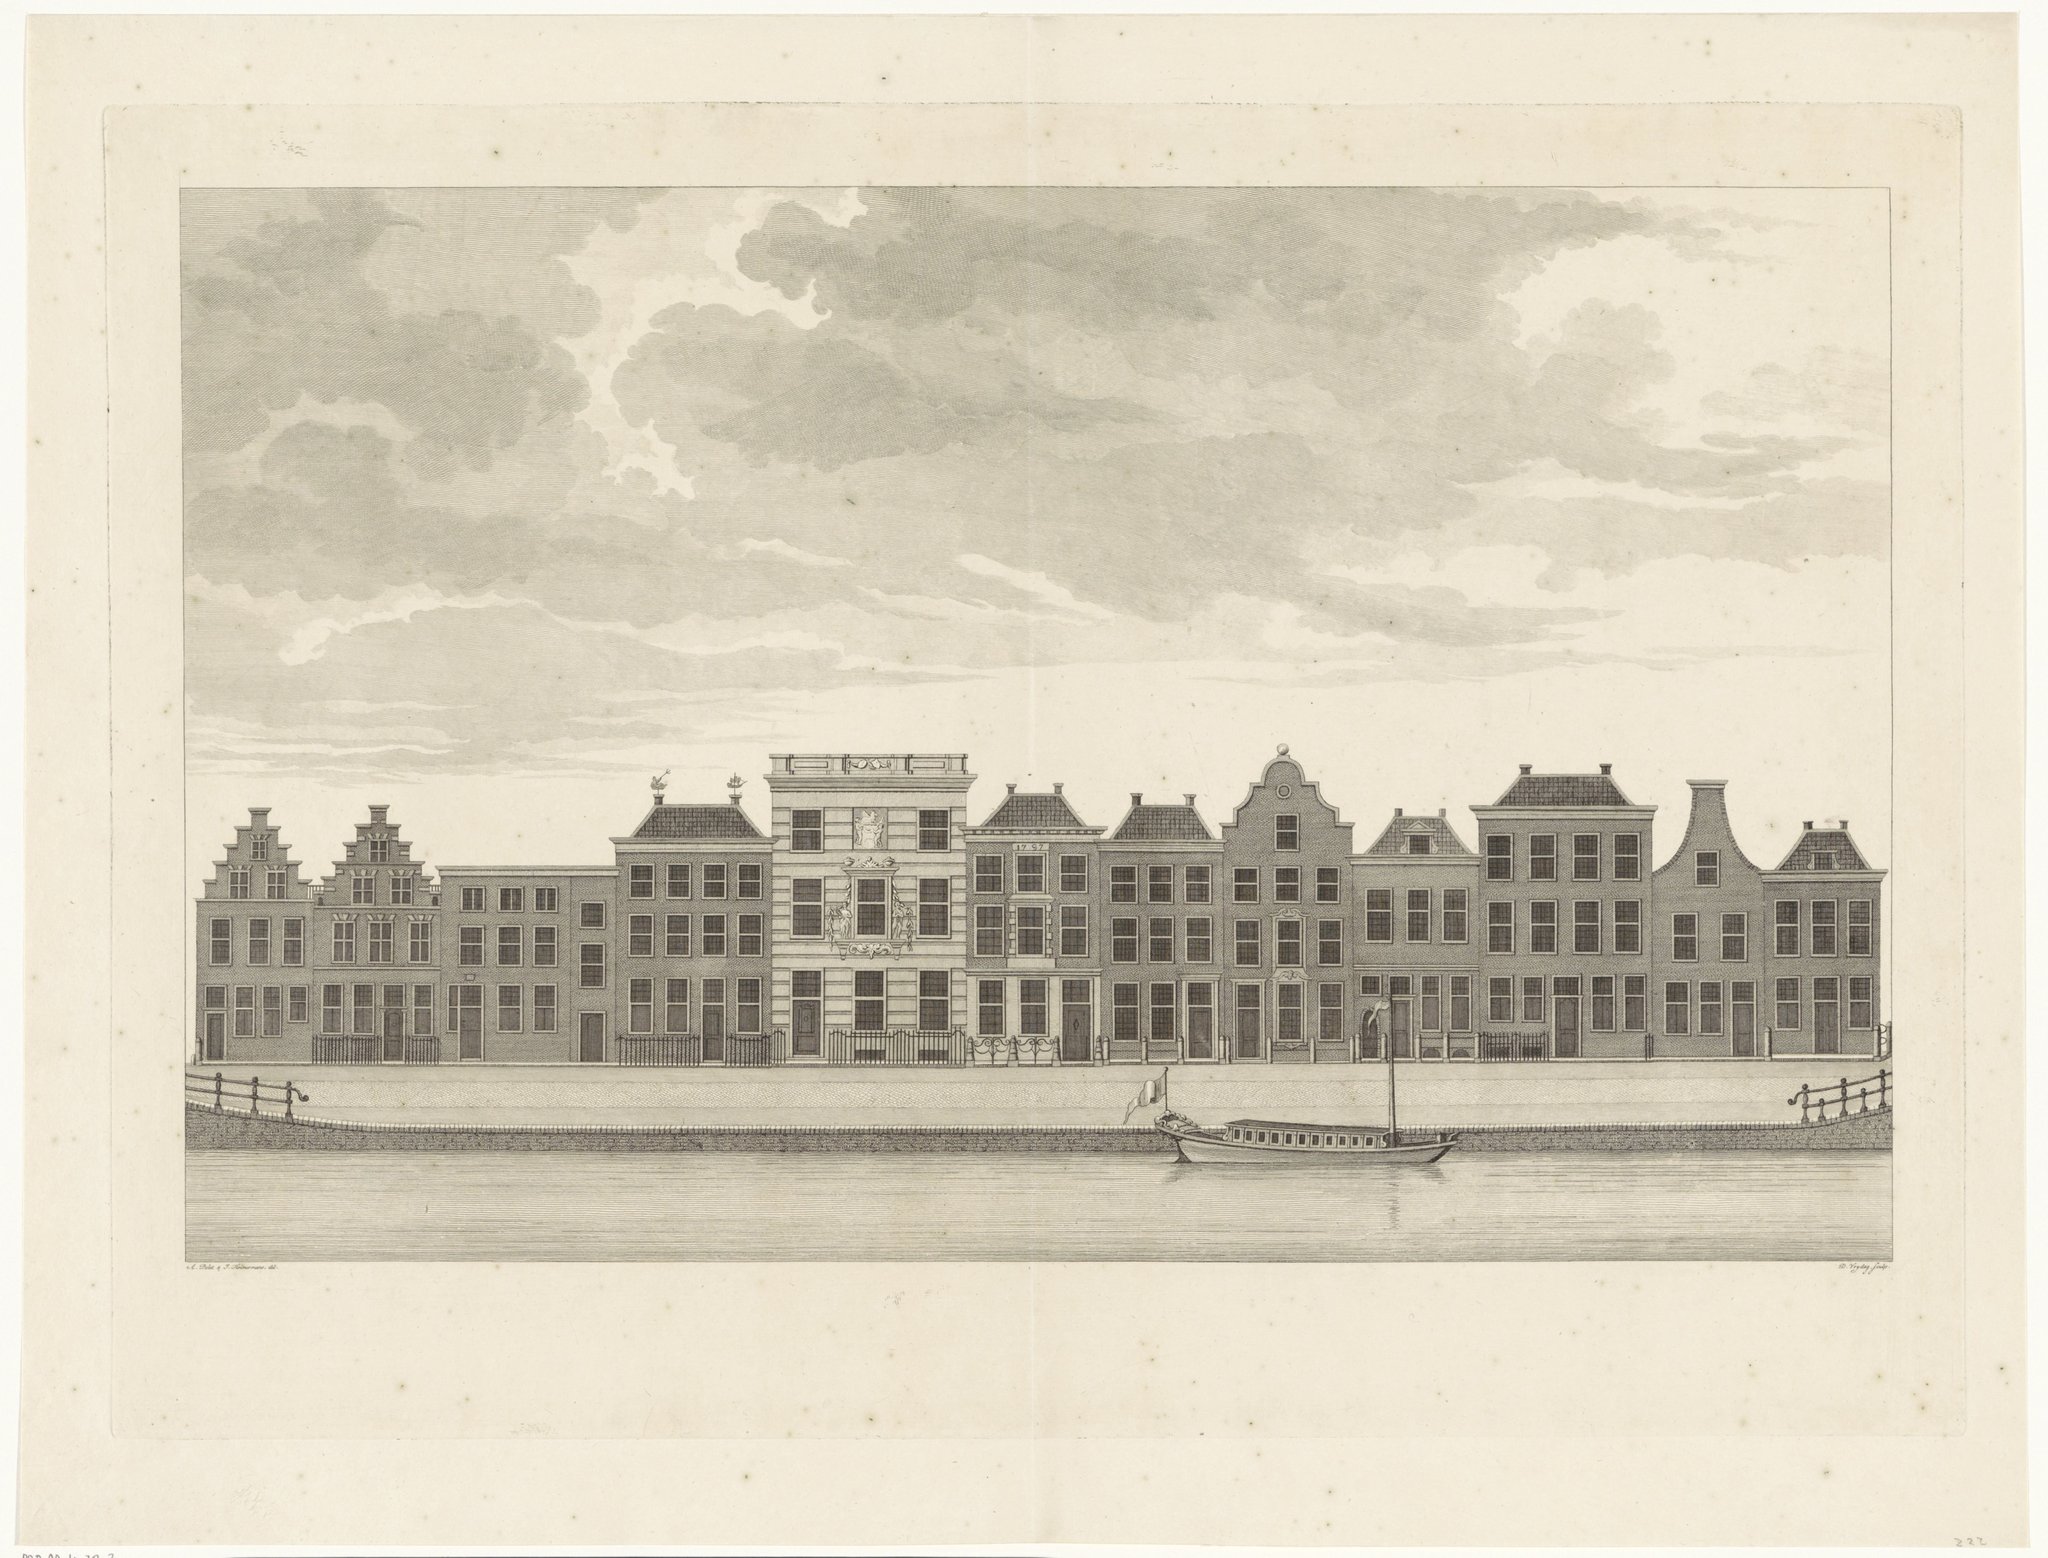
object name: history print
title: Gezicht op de huizen aan het Rapenburg te Leiden, van de Koepoortsgracht tot de Sint Jacobsgracht, voorafgaand aan de ramp van Leiden, 1807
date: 1807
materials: paper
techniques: engraving, etching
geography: amsterdam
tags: façade (of house or building), leiden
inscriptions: collector's mark: Lugt 2228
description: Gezicht op de gevels van de huizen aan het Rapenburg te Leiden, van de Koepoortsgracht tot de Sint Jacobsgracht. Situatie voor de ontploffing van het kruitschip op 12 januari 1807. Met een lege marge.